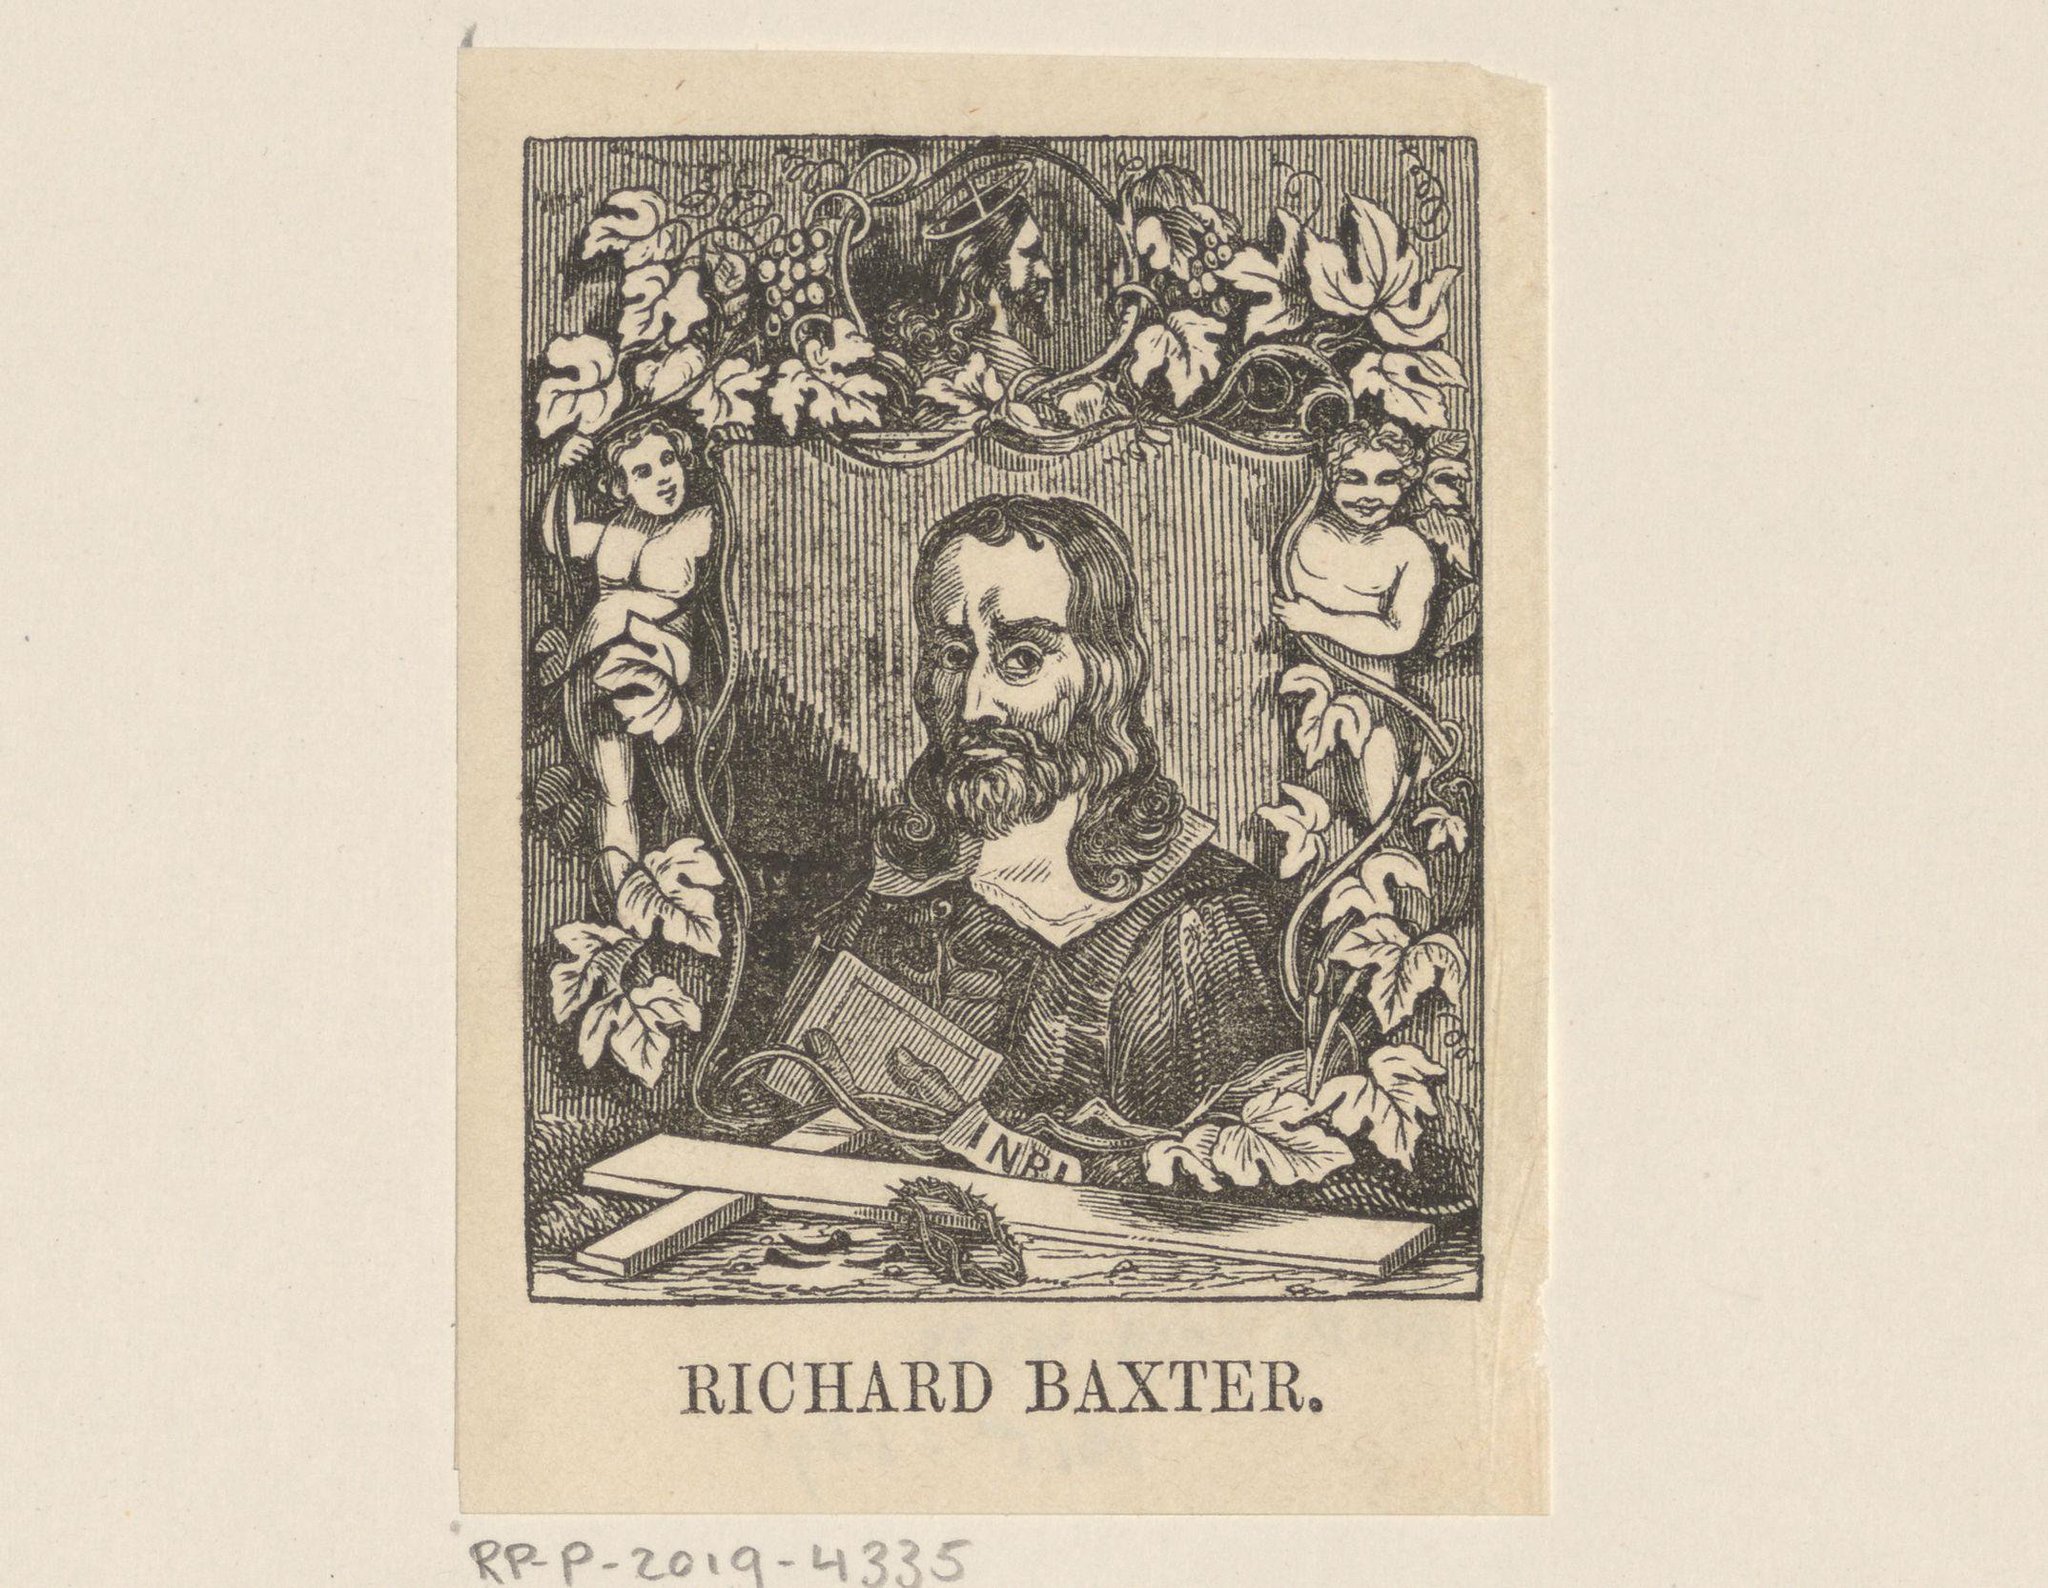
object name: print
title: Portret van Richard Baxter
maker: Anonymous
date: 1750-1849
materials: paper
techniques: letterpress printing, engraving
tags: london, historical persons, christ